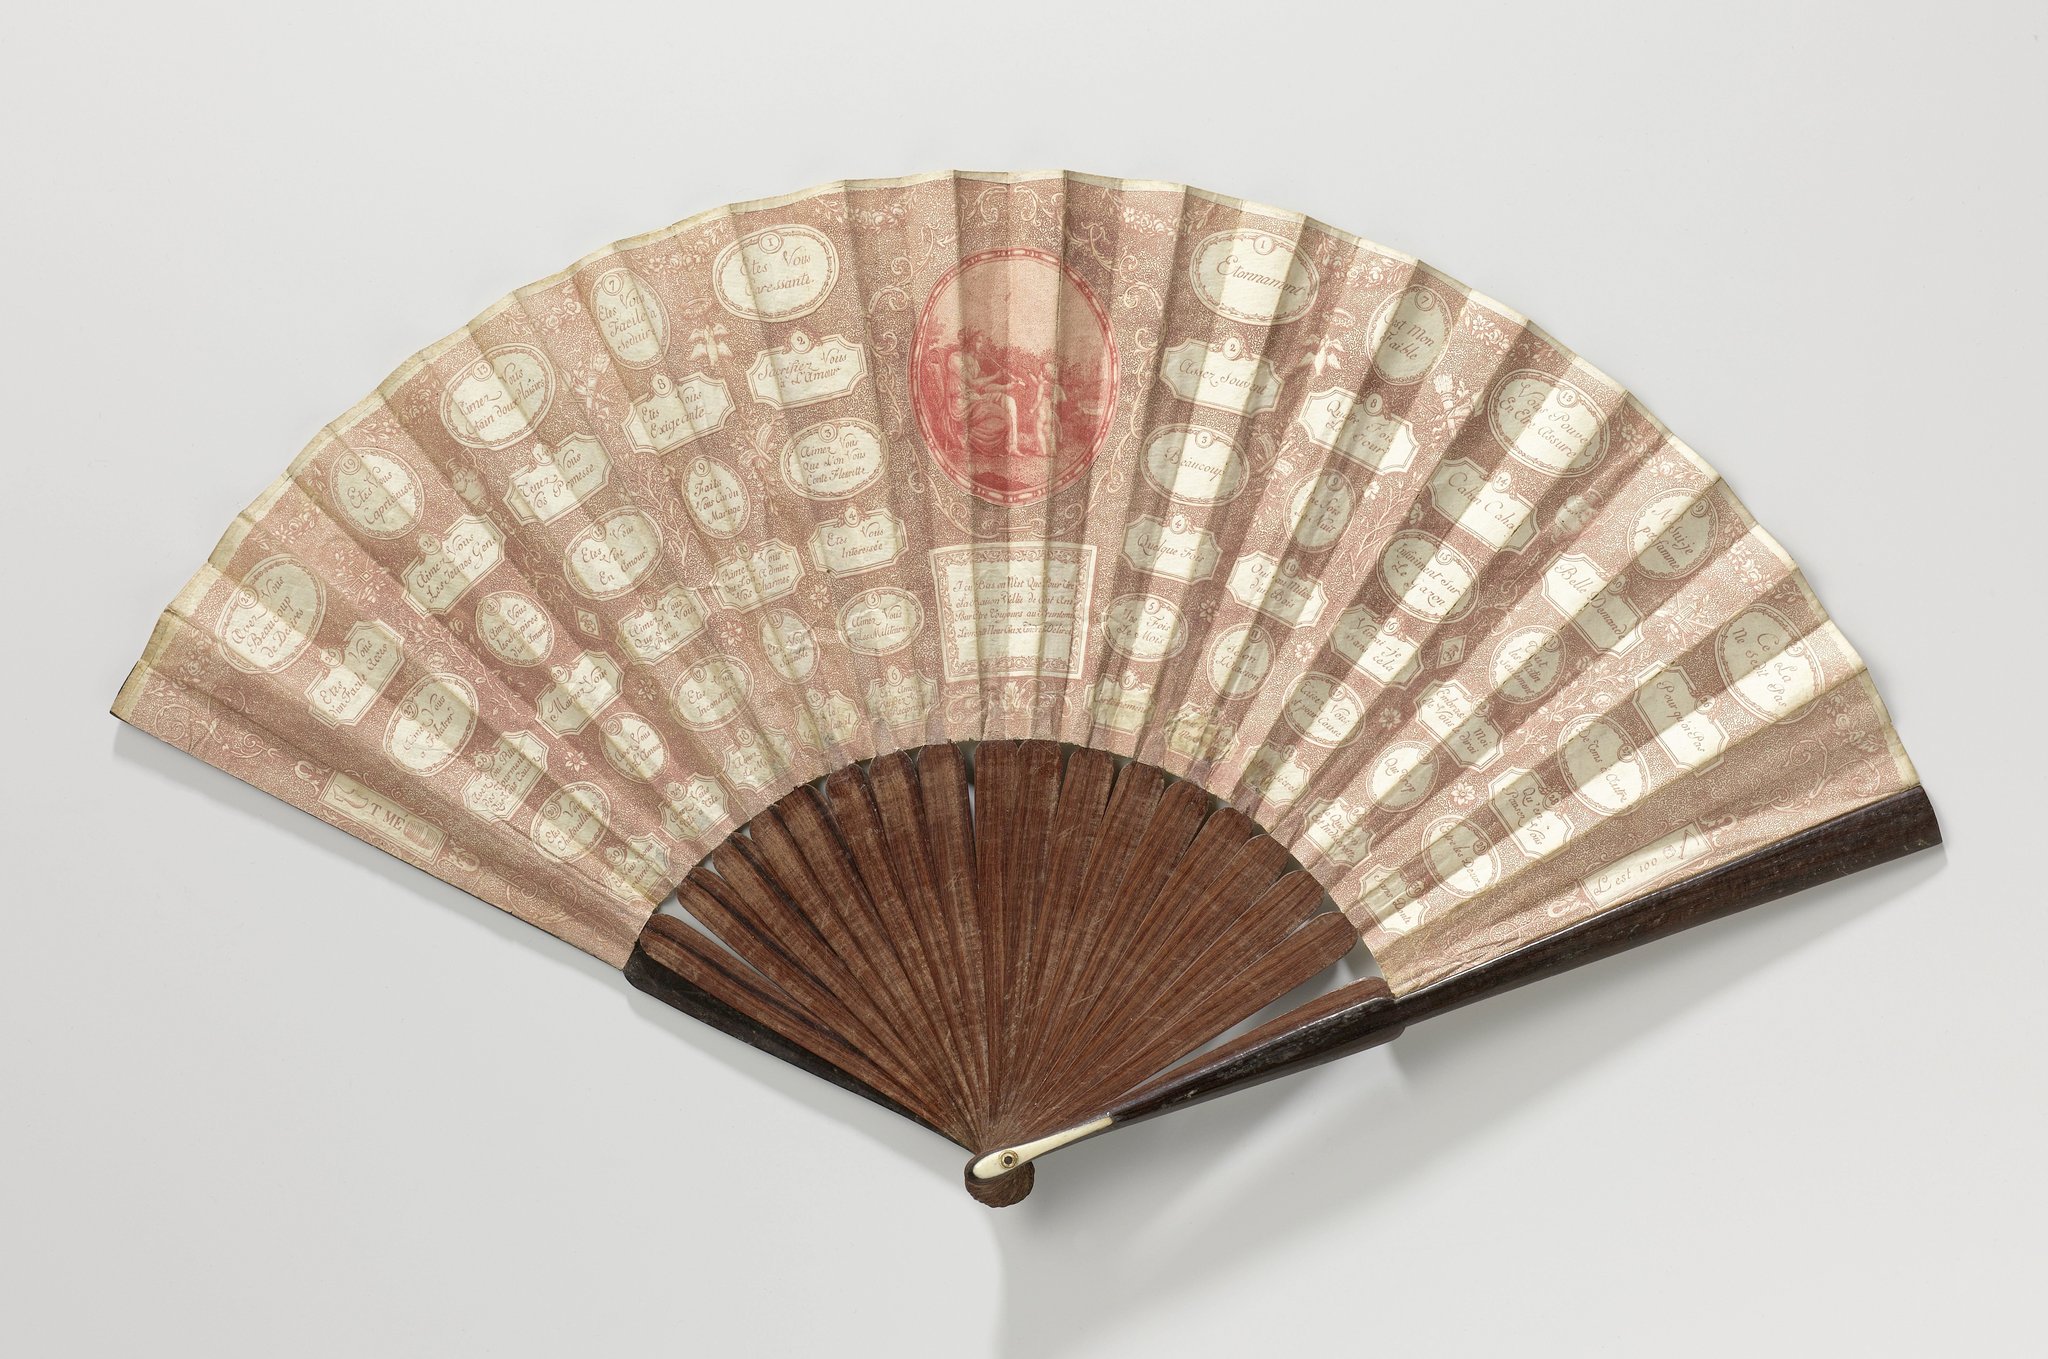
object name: vouwwaaier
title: Vouwwaaier met dubbel blad van papier waarop aan de voorkant met rode inkt een vraag- en antwoordspel gedrukt, op een montuur van padoek- en ebbenhout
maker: Anonymous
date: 1790-1800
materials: bone, wood, ink, paper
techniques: cutting, printing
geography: france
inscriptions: : ‘Elle est sans défauts’, poem: ‘Livronts Nous Aux Tendres Delires’, : ‘Sa beauté m'étonne’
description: Deze geëtste waaierbladen werden in grote oplage gedrukt en gemonteerd op eenvoudige houten monturen. Enige variatie werd verkregen door het aanbrengen van andere stippelgravures of door een andere kleur drukinkt te gebruiken. Zo bevindt zich in de verzameling van Felix Tal in Museum Beeckestijn eenzelfde exemplaar, dat uitsluitend afwijkt in de kleur (blauw) en in de voorstelling in het midden. Het waren goedkope waaiers die niet altijd even nauwkeurig werden gemonteerd, zoals ook het geval is bij dit voorbeeld. Dat het vraag- en antwoordspel op de voorkant over de liefde gaat, blijkt vooral uit de tekst onder de opgeplakte stippelgravure. Deze eindigt met de zin 'Livronts Nous Aux Tendres Delires'of 'Laten wij ons overgeven aan de zoete waanzin'. Het spel werd gespeeld doordat de minnaar een willekeurige vraag op de linkerhelft van het blad koos en zijn geliefde hem hieropantwoordde met een willekeurig gekozen antwoord van de rechterkant. Verder kon men ook nog een rebus op ieder van de buitenbenen oplossen: links 'sa beauté m'étonne' en rechts 'elle est sans défauts'. Tussen de cartouches en medaillons met de vragen en antwoorden zijn de overbekende pastorale en liefdessymbolen aangebracht. Het classicistische element wordt benadrukt door de vazen, arabesken en de voorstelling op de stippelgravure. Het blad is aan de achterkant onversierd.